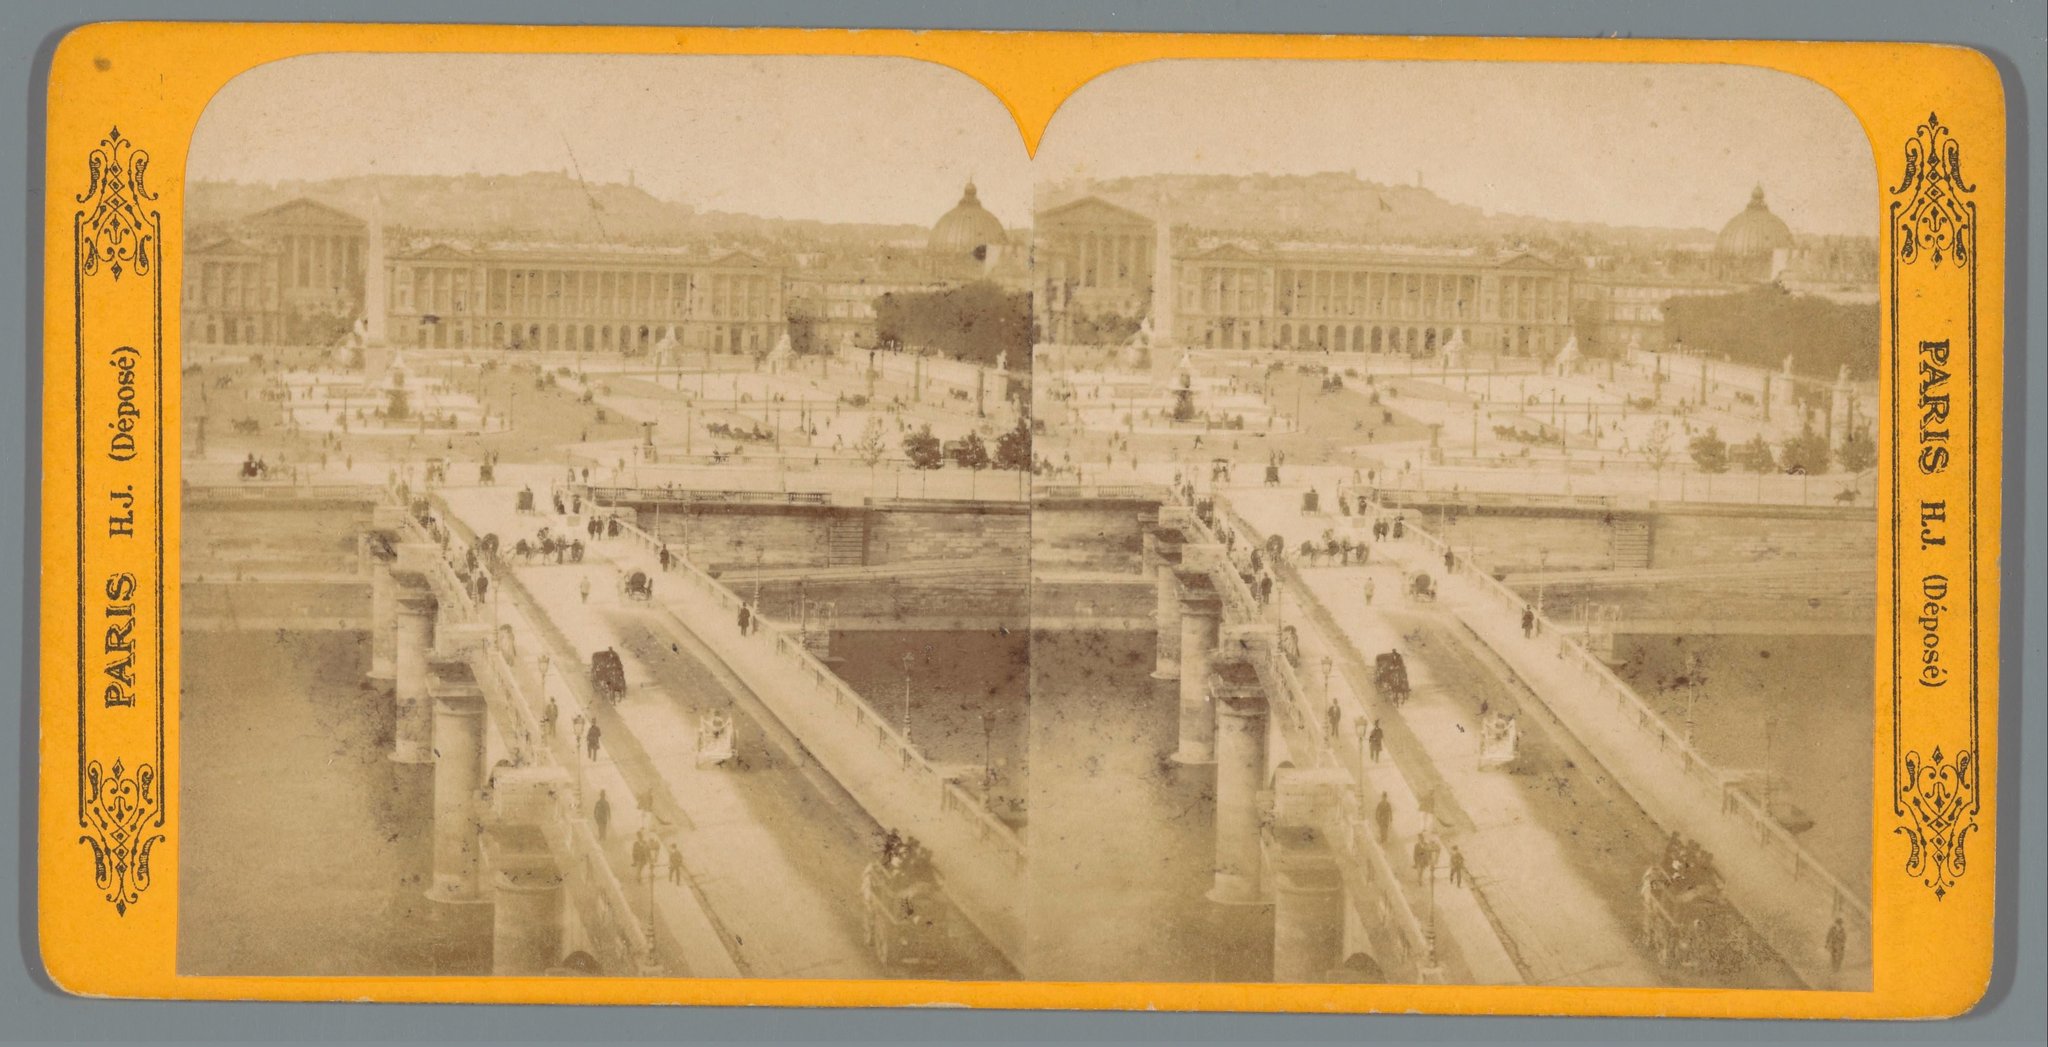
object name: stereograph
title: Gezicht op de Pont de la Concorde, Place de la Concorde en La Madeleine in Parijs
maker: hippolyte jouvin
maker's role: fotograaf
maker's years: 1825-1889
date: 1850-1880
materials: cardboard, photographic support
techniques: albumen print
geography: paris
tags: square, place, circus, etc., bridge in city across river, canal, etc.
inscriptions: number: ‘No. 72’, inscription: ‘Pont et Place de la Concorde’